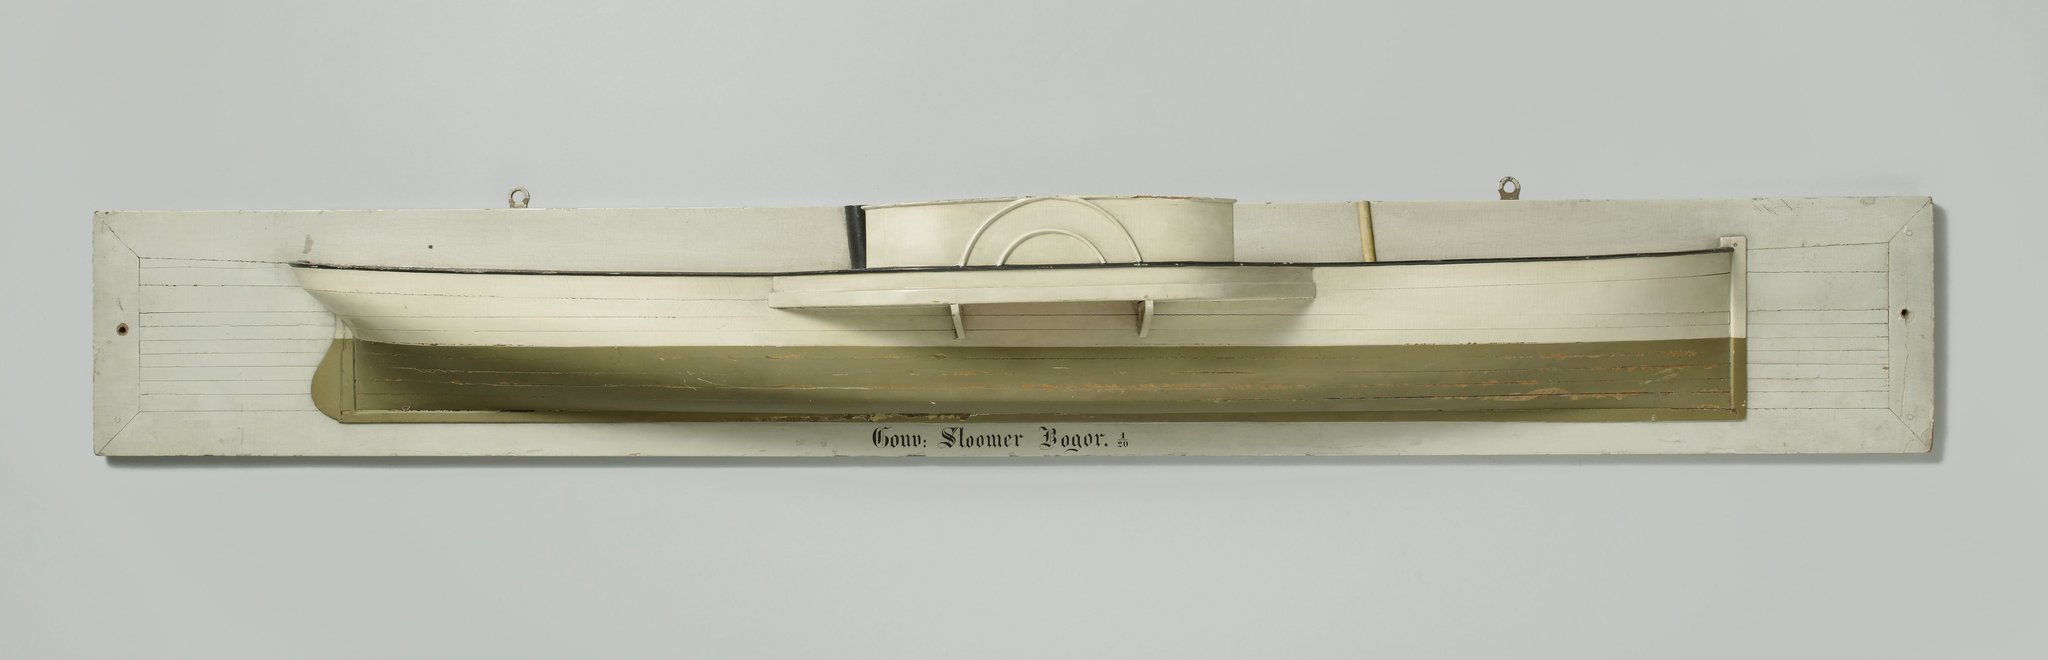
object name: half model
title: Half Model of a Paddle Steamer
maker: Anonymous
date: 1873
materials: wood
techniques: polychromy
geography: surabaya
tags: bogor (schip)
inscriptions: inscription, bottom centre, in a Gothic hand: ‘Gouv: Stoomer Bogor. 1/20’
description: Gepolychromeerd stapelmodel (stuurboord) van een eenmast raderstoomschip. Rechte verticale voorsteven. Elliptisch hek met roer met ronde roerkoning (Amerikaans roer) en afgerond blad. Eén gesloten raderkast ondersteund door raderbalken in de zijde, een schoorsteen aan dek. De zeeg loopt naar beide uiteinden een weinig op; het onderwaterschip is een rondspant met vlakke bodem. Het model heeft slechts een enkele fokkemast. Achterop het model spant- en waterlijnen en aantekeningen voor de werf. Schaal 1:20 (schaal op model).